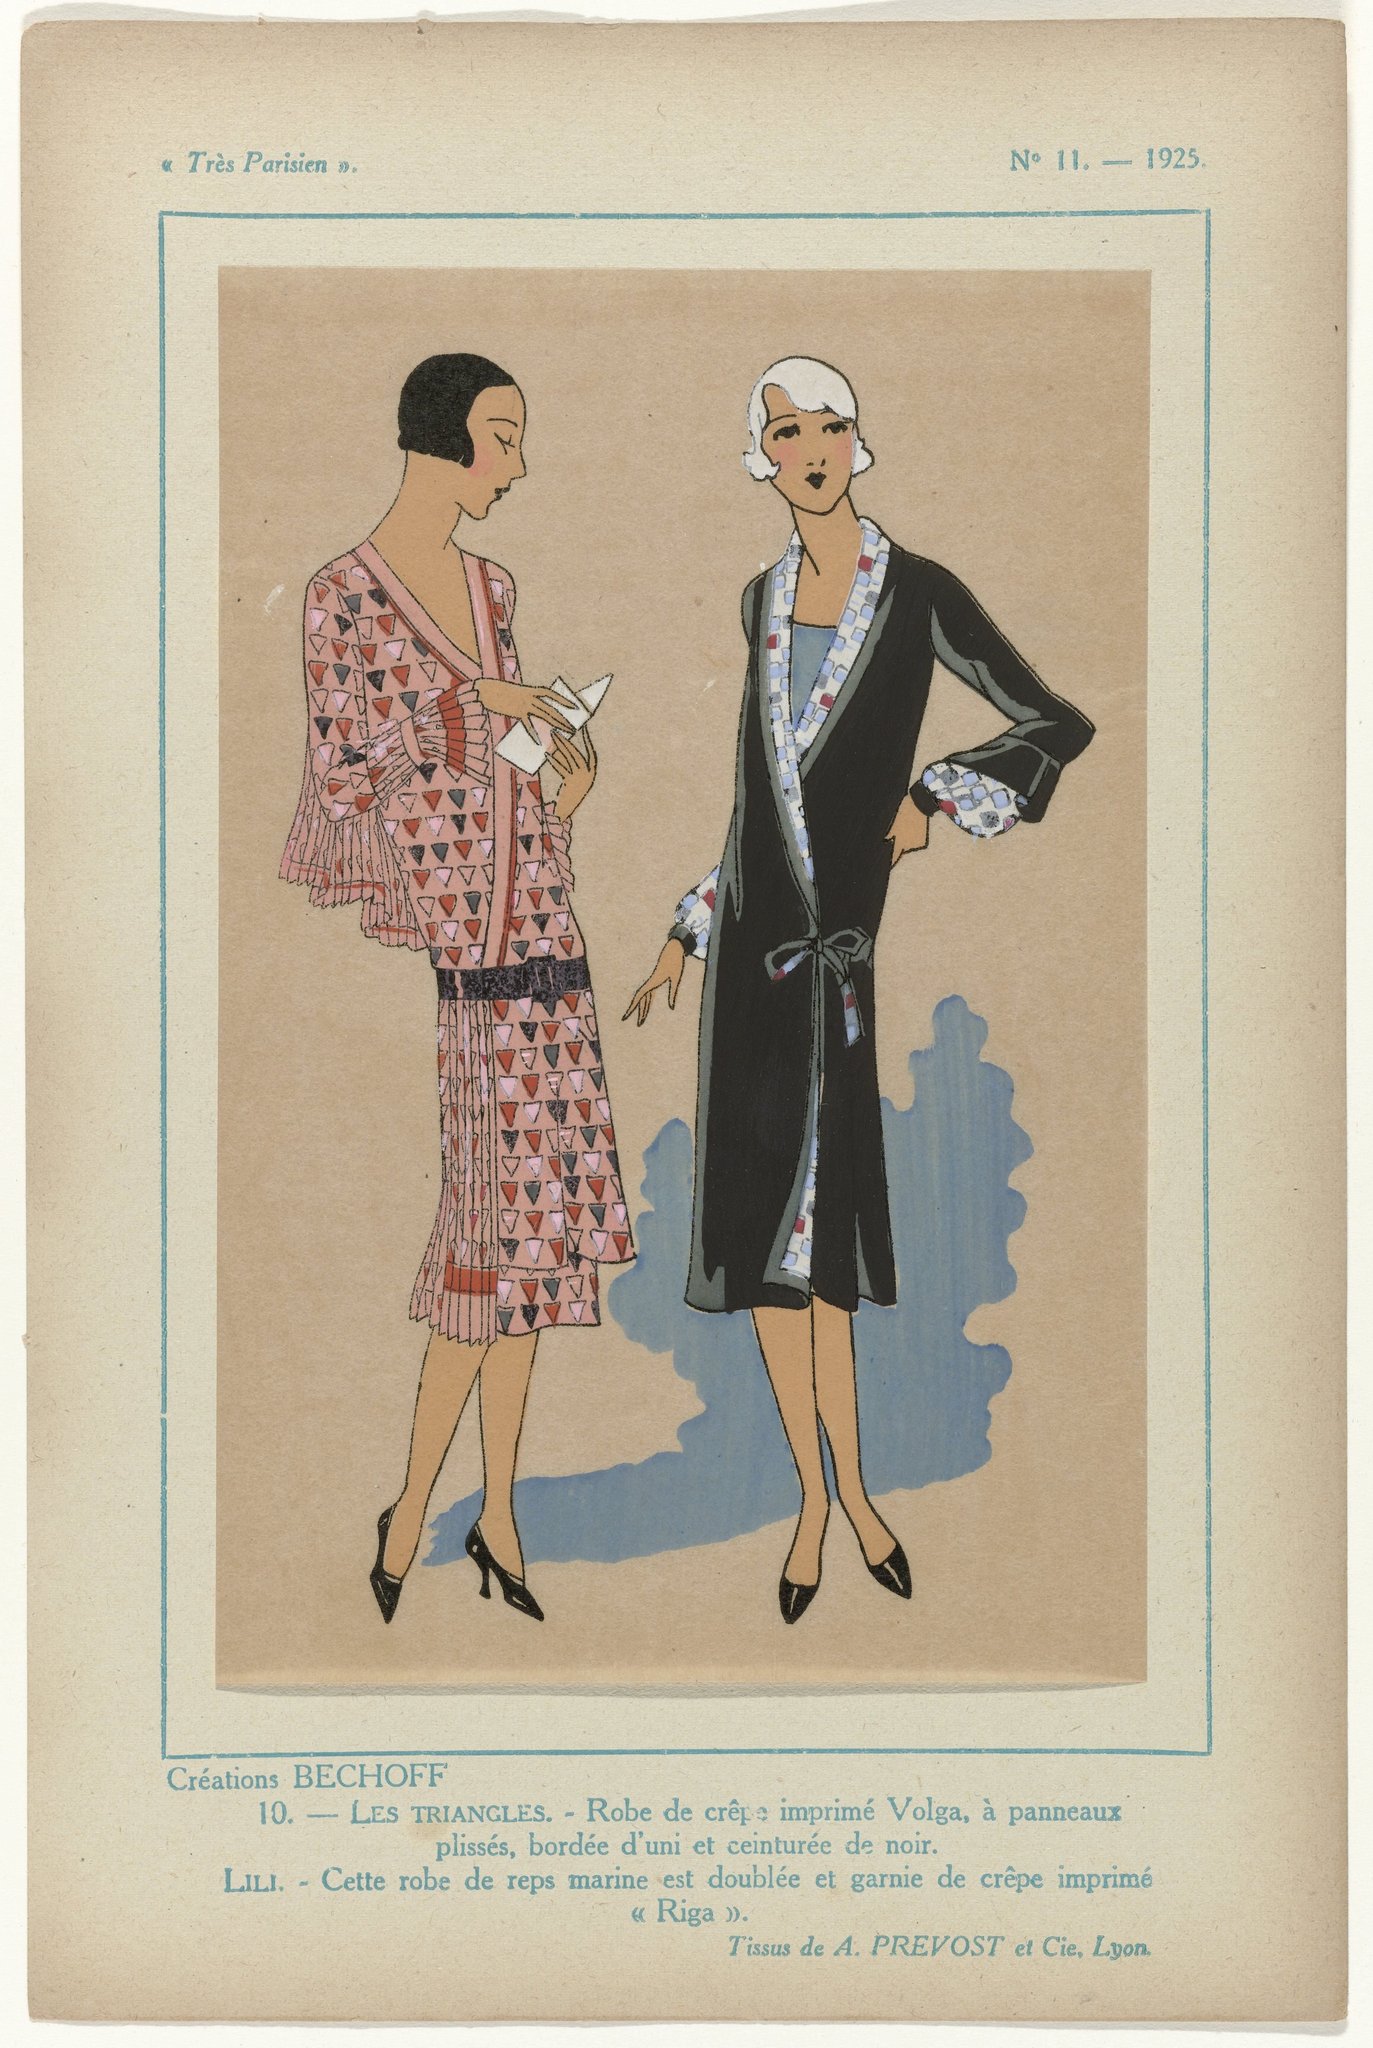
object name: fashion print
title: Très Parisien, 1925, No. 11, Pl.10: Créations BECHOFF - LES TRIANGLES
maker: g-p. joumard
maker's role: publisher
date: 1925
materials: paper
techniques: hand coloring, letterpress printing, lithography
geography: paris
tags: dress, gown: day dress (+ women's clothes), fashion plates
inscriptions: caption: ‘10. - LES TRIANGLES. - Robe de crêpe imprimé Volga, à panneaux plissés, bordée d'uni et ceinturée de noir. LILI.- Cette robe de reps marine est doublée et garnie de crêpe imprimé "Riga".’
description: Twee creaties van Bechoff, uitgevoerd in stoffen van A. Prévost, Lyon. Japon van bedrukte crêpe en een japon in marineblauw , gevoerd met een bedrukte stof. Prent uit het modetijdschrift Très Parisien...La Mode, Le Chic, L'Élégance (1920-1936)